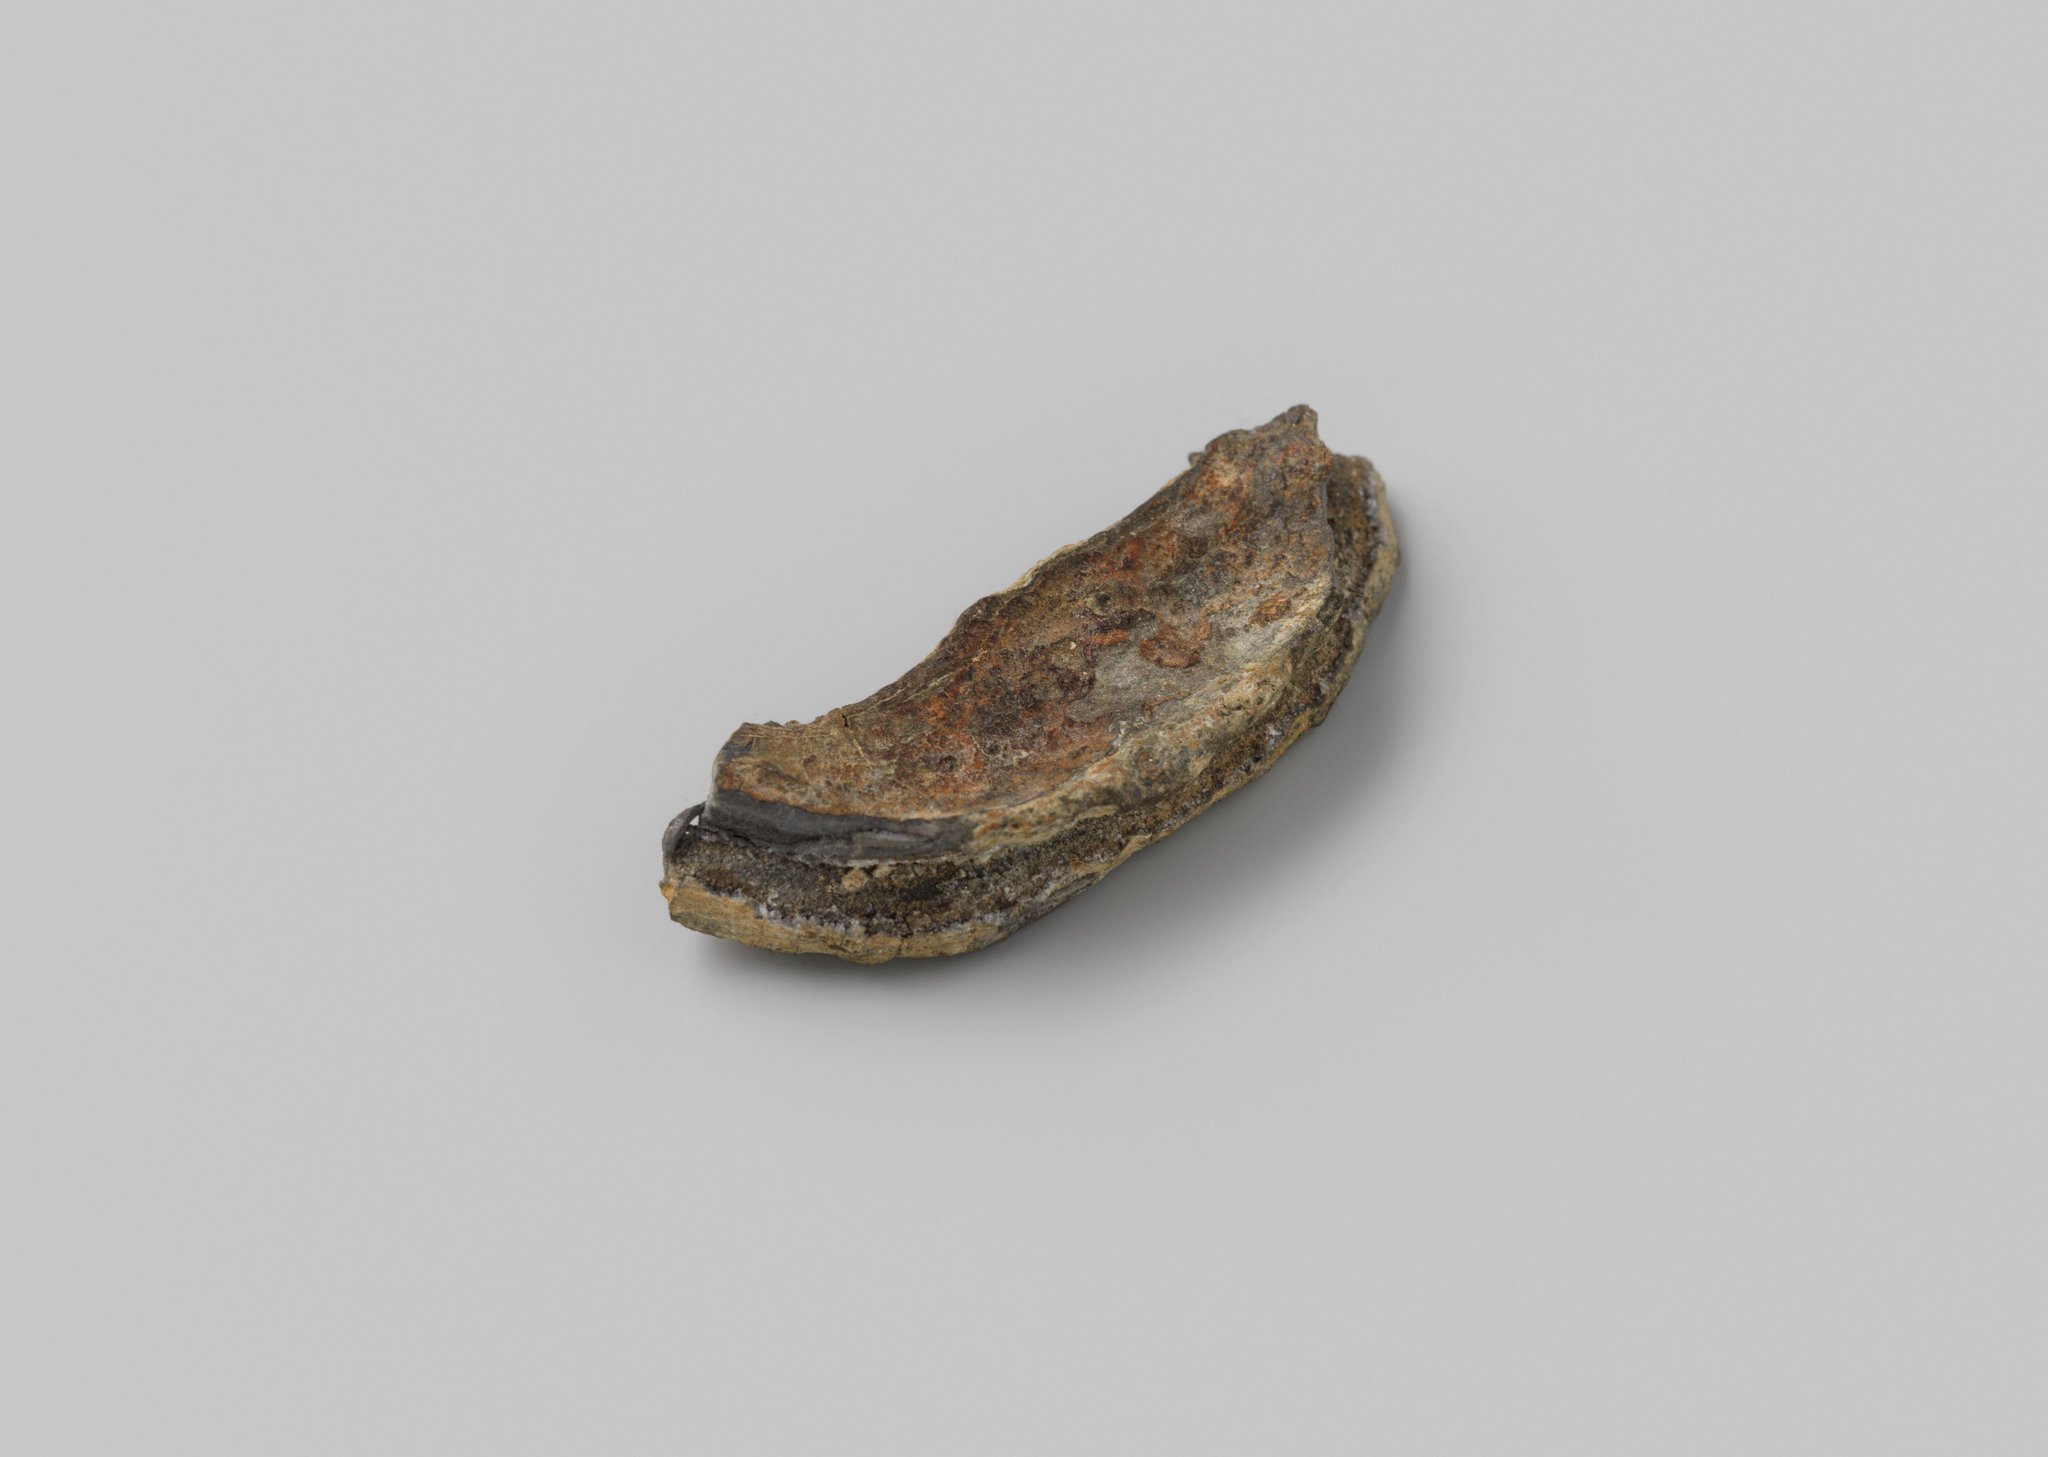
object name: part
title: Mechanisch onderdeel, halfrond, uit het wrak van de Oost-Indiëvaarder Hollandia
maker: Anonymous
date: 1700-1743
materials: tin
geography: netherlands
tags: verenigde oostindische compagnie, hollandia (schip), annet